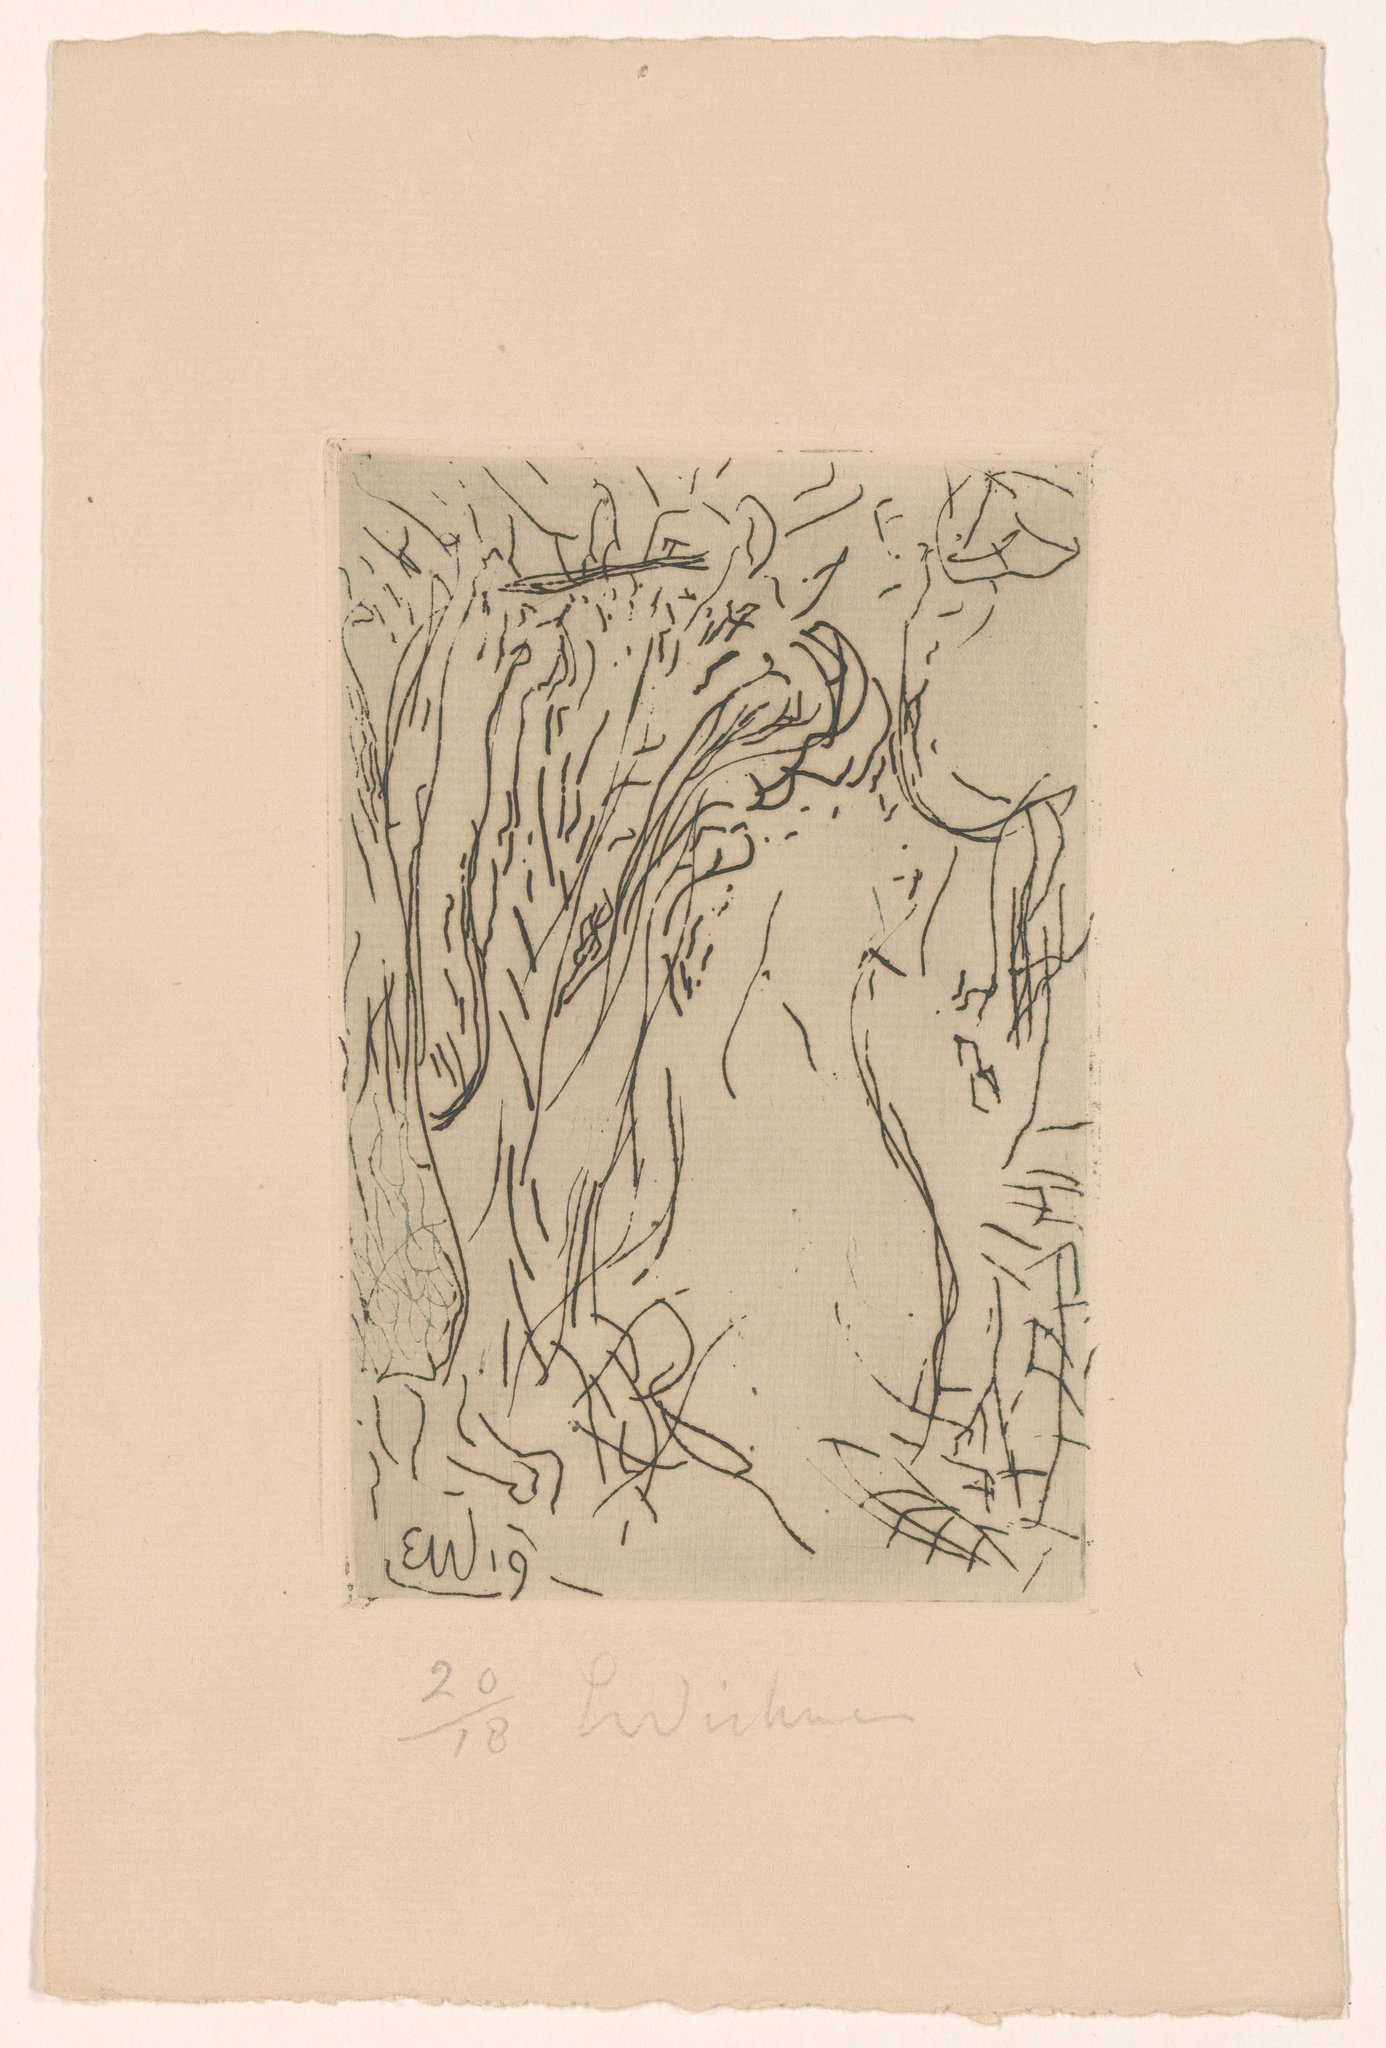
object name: print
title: Geabstraheerd bosgezicht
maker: erich wichmann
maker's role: print maker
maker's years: 1890-1929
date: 1919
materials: paper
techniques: etching, intaglio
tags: abstract, non-representational art, forest, wood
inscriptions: collector's mark: Lugt 2228, collector's mark: Lugt 2760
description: Prent mogelijk geïnspireerd op gedichten van Charles Baudelaire en Paul Verlaine.